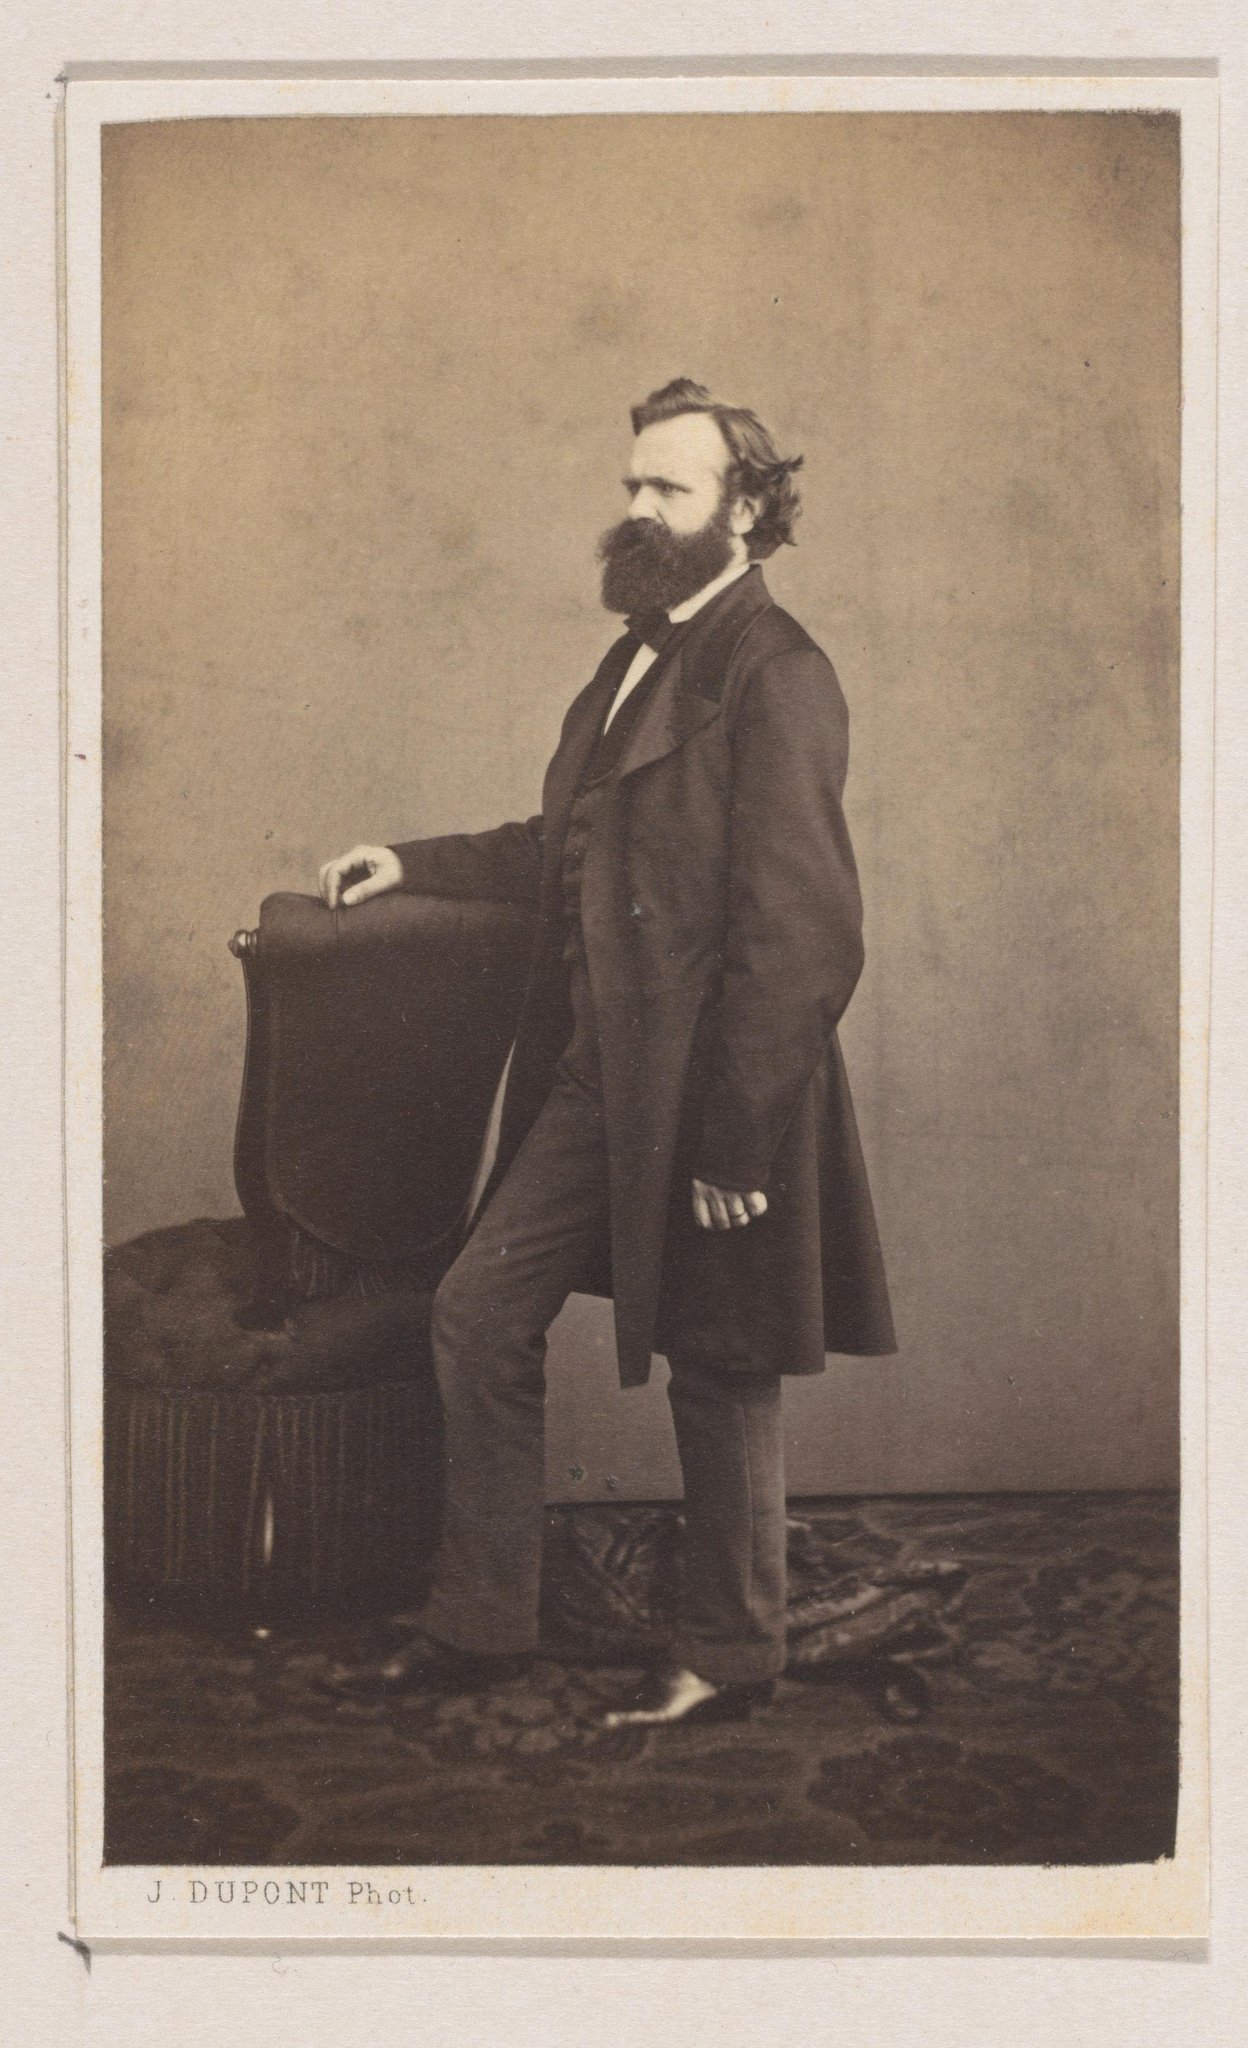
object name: carte de visite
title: L'École d'Anvers. Portraits biographies cartes de visite. Collection Dupont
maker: joseph dupont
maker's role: fotograaf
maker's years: 1818-1901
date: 1861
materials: cardboard, paper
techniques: albumen print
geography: antwerp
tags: riesenbeck, antwerp, johan bernhard wittkamp, historical persons, portrait, self-portrait of painter, portrait, self-portrait of artist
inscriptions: inscription: ‘ETABLISSEMENT PHOTOGRAPHIQUE/ de/ J. DUPONT/ Place de Meir 32/ ANVERS/ Maison fondée en 1853’